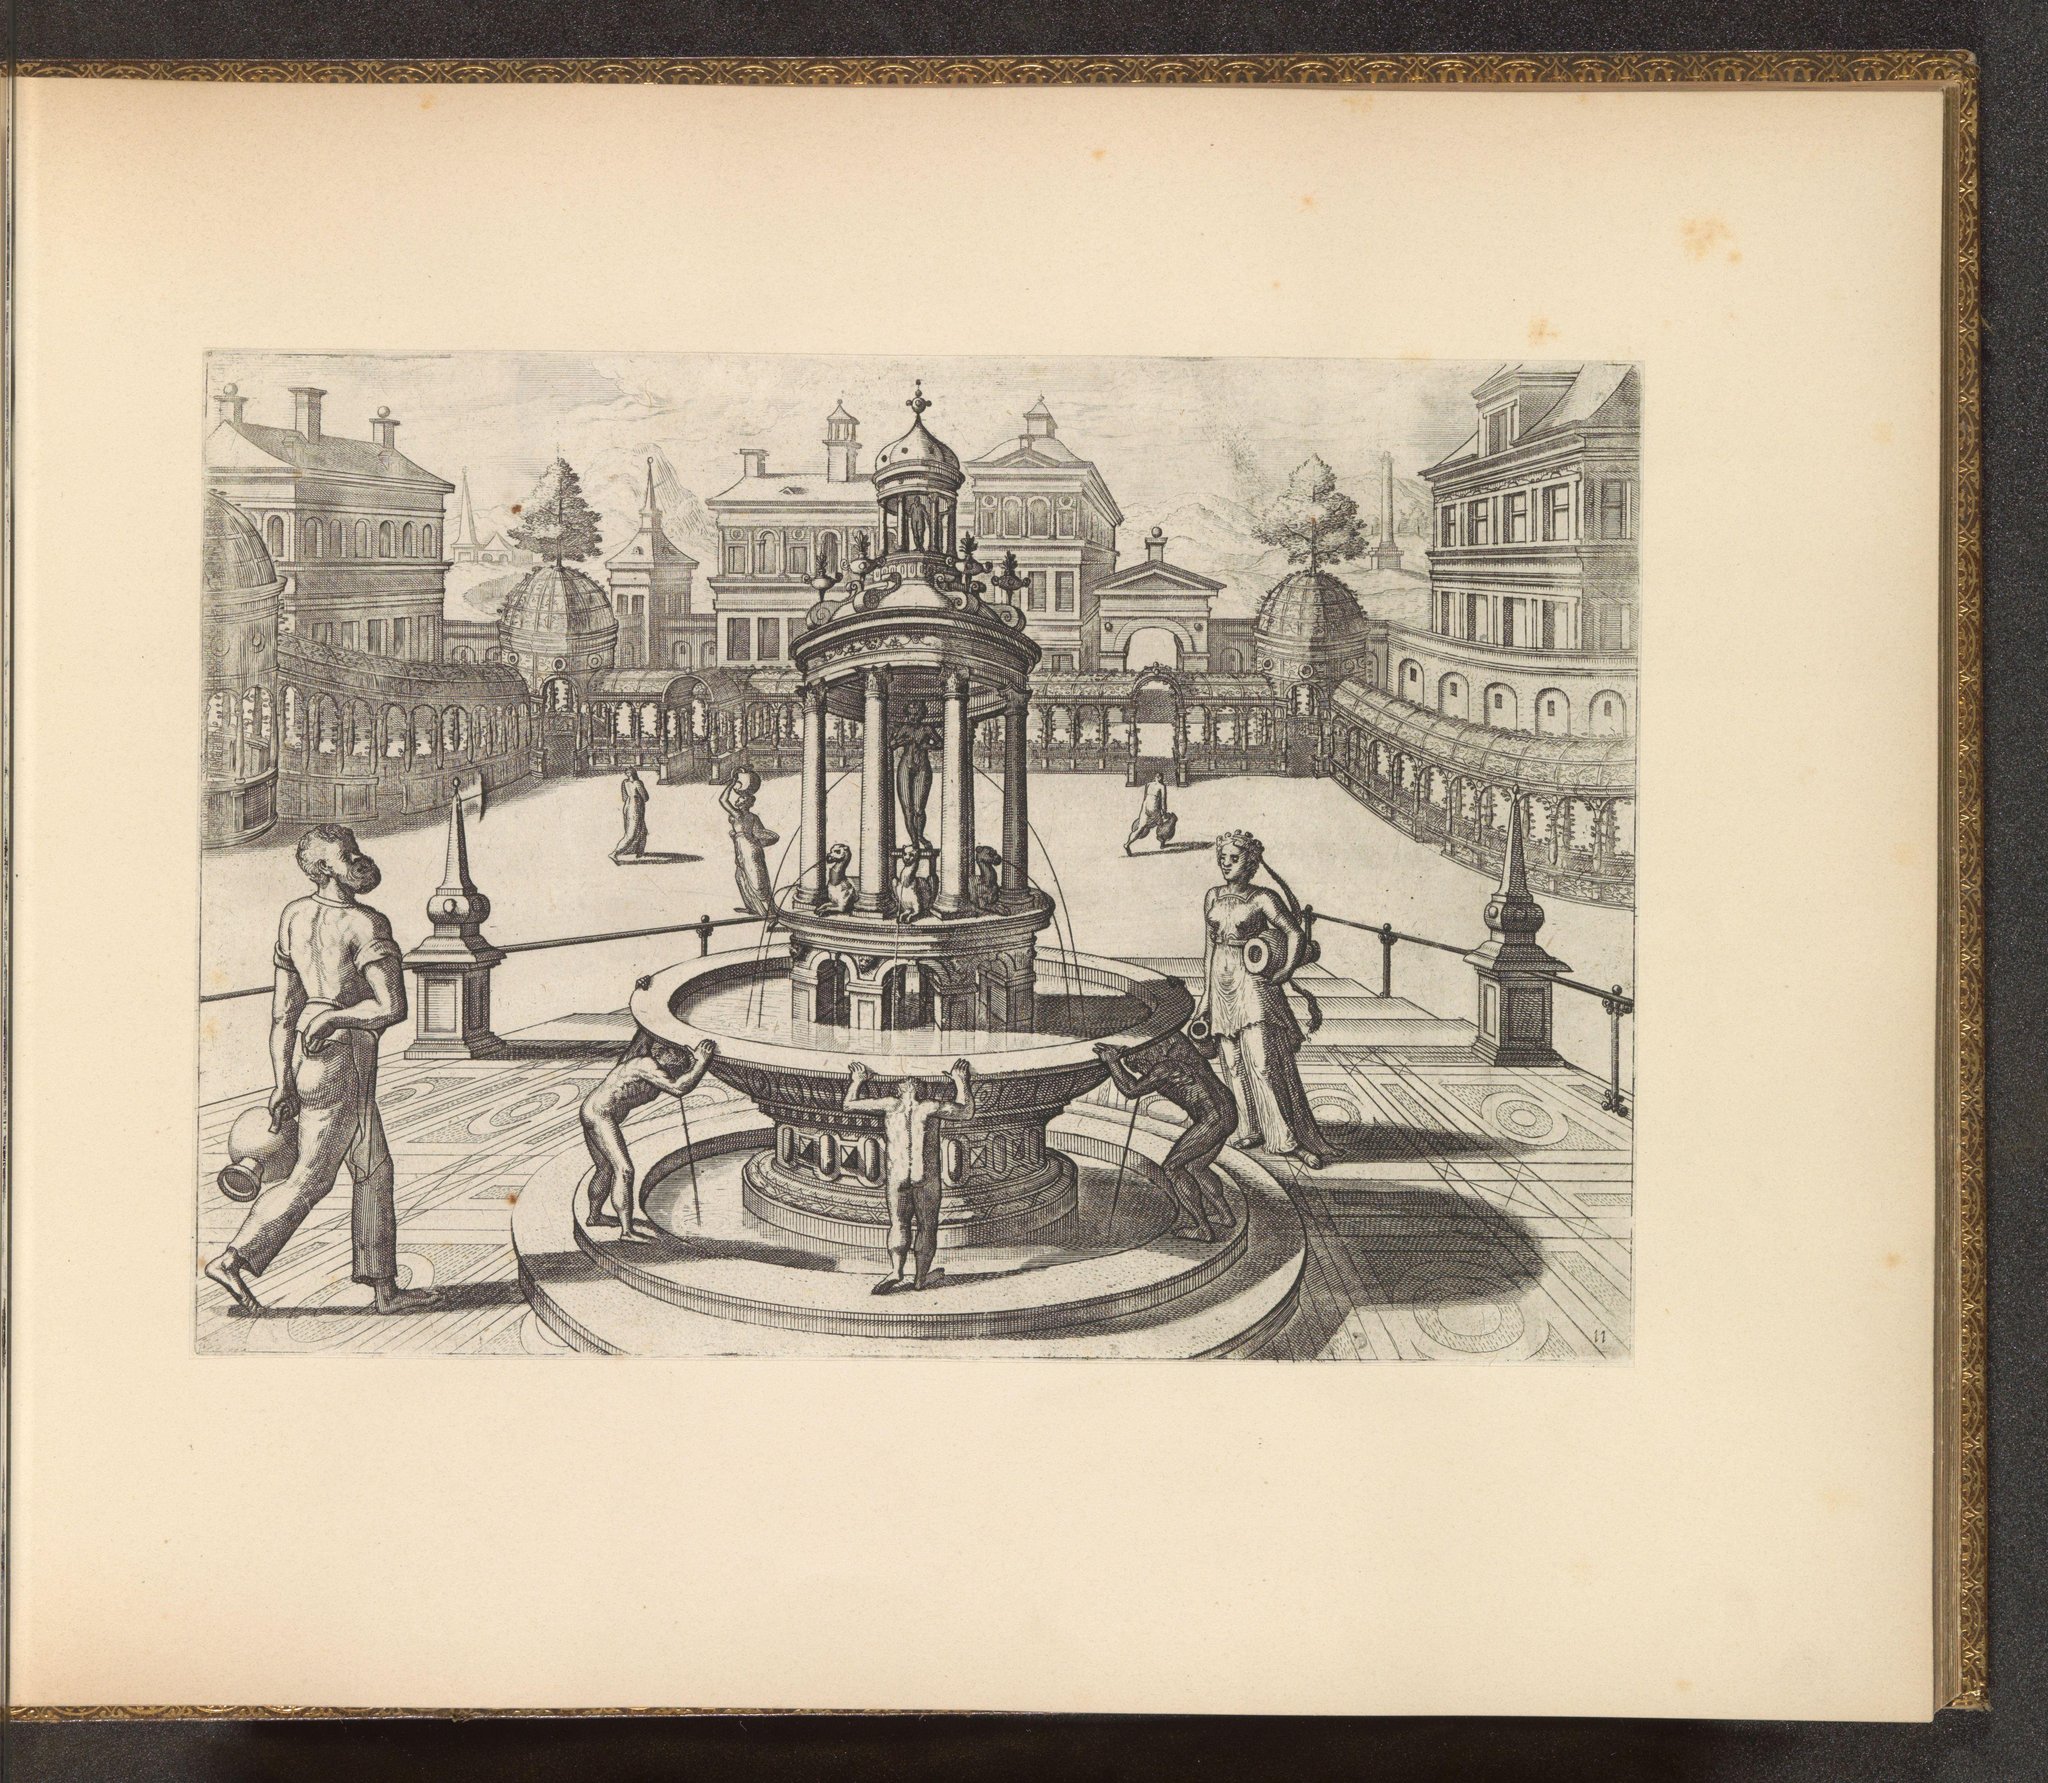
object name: ornament print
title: Fontein bekroond met rond tempeltje op plein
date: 1600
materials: paper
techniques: etching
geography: antwerp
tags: piece of sculpture, reproduction of a piece of sculpture, ornamental fountain, village square, place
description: Plein met een ronde fontein, bestaande uit een bekken waar drie water spuwende kinderen of mannen tegen aan staan. In het bekken staat een ronde tempel van twee verdiepingen waarin zich een vrouw bevindt met drie leeuwen onder haar voeten. Rond de fontein mannen en vrouwen met kruiken. Rond het plein een gang van traliewerk. De prent maakt deel uit van een album.